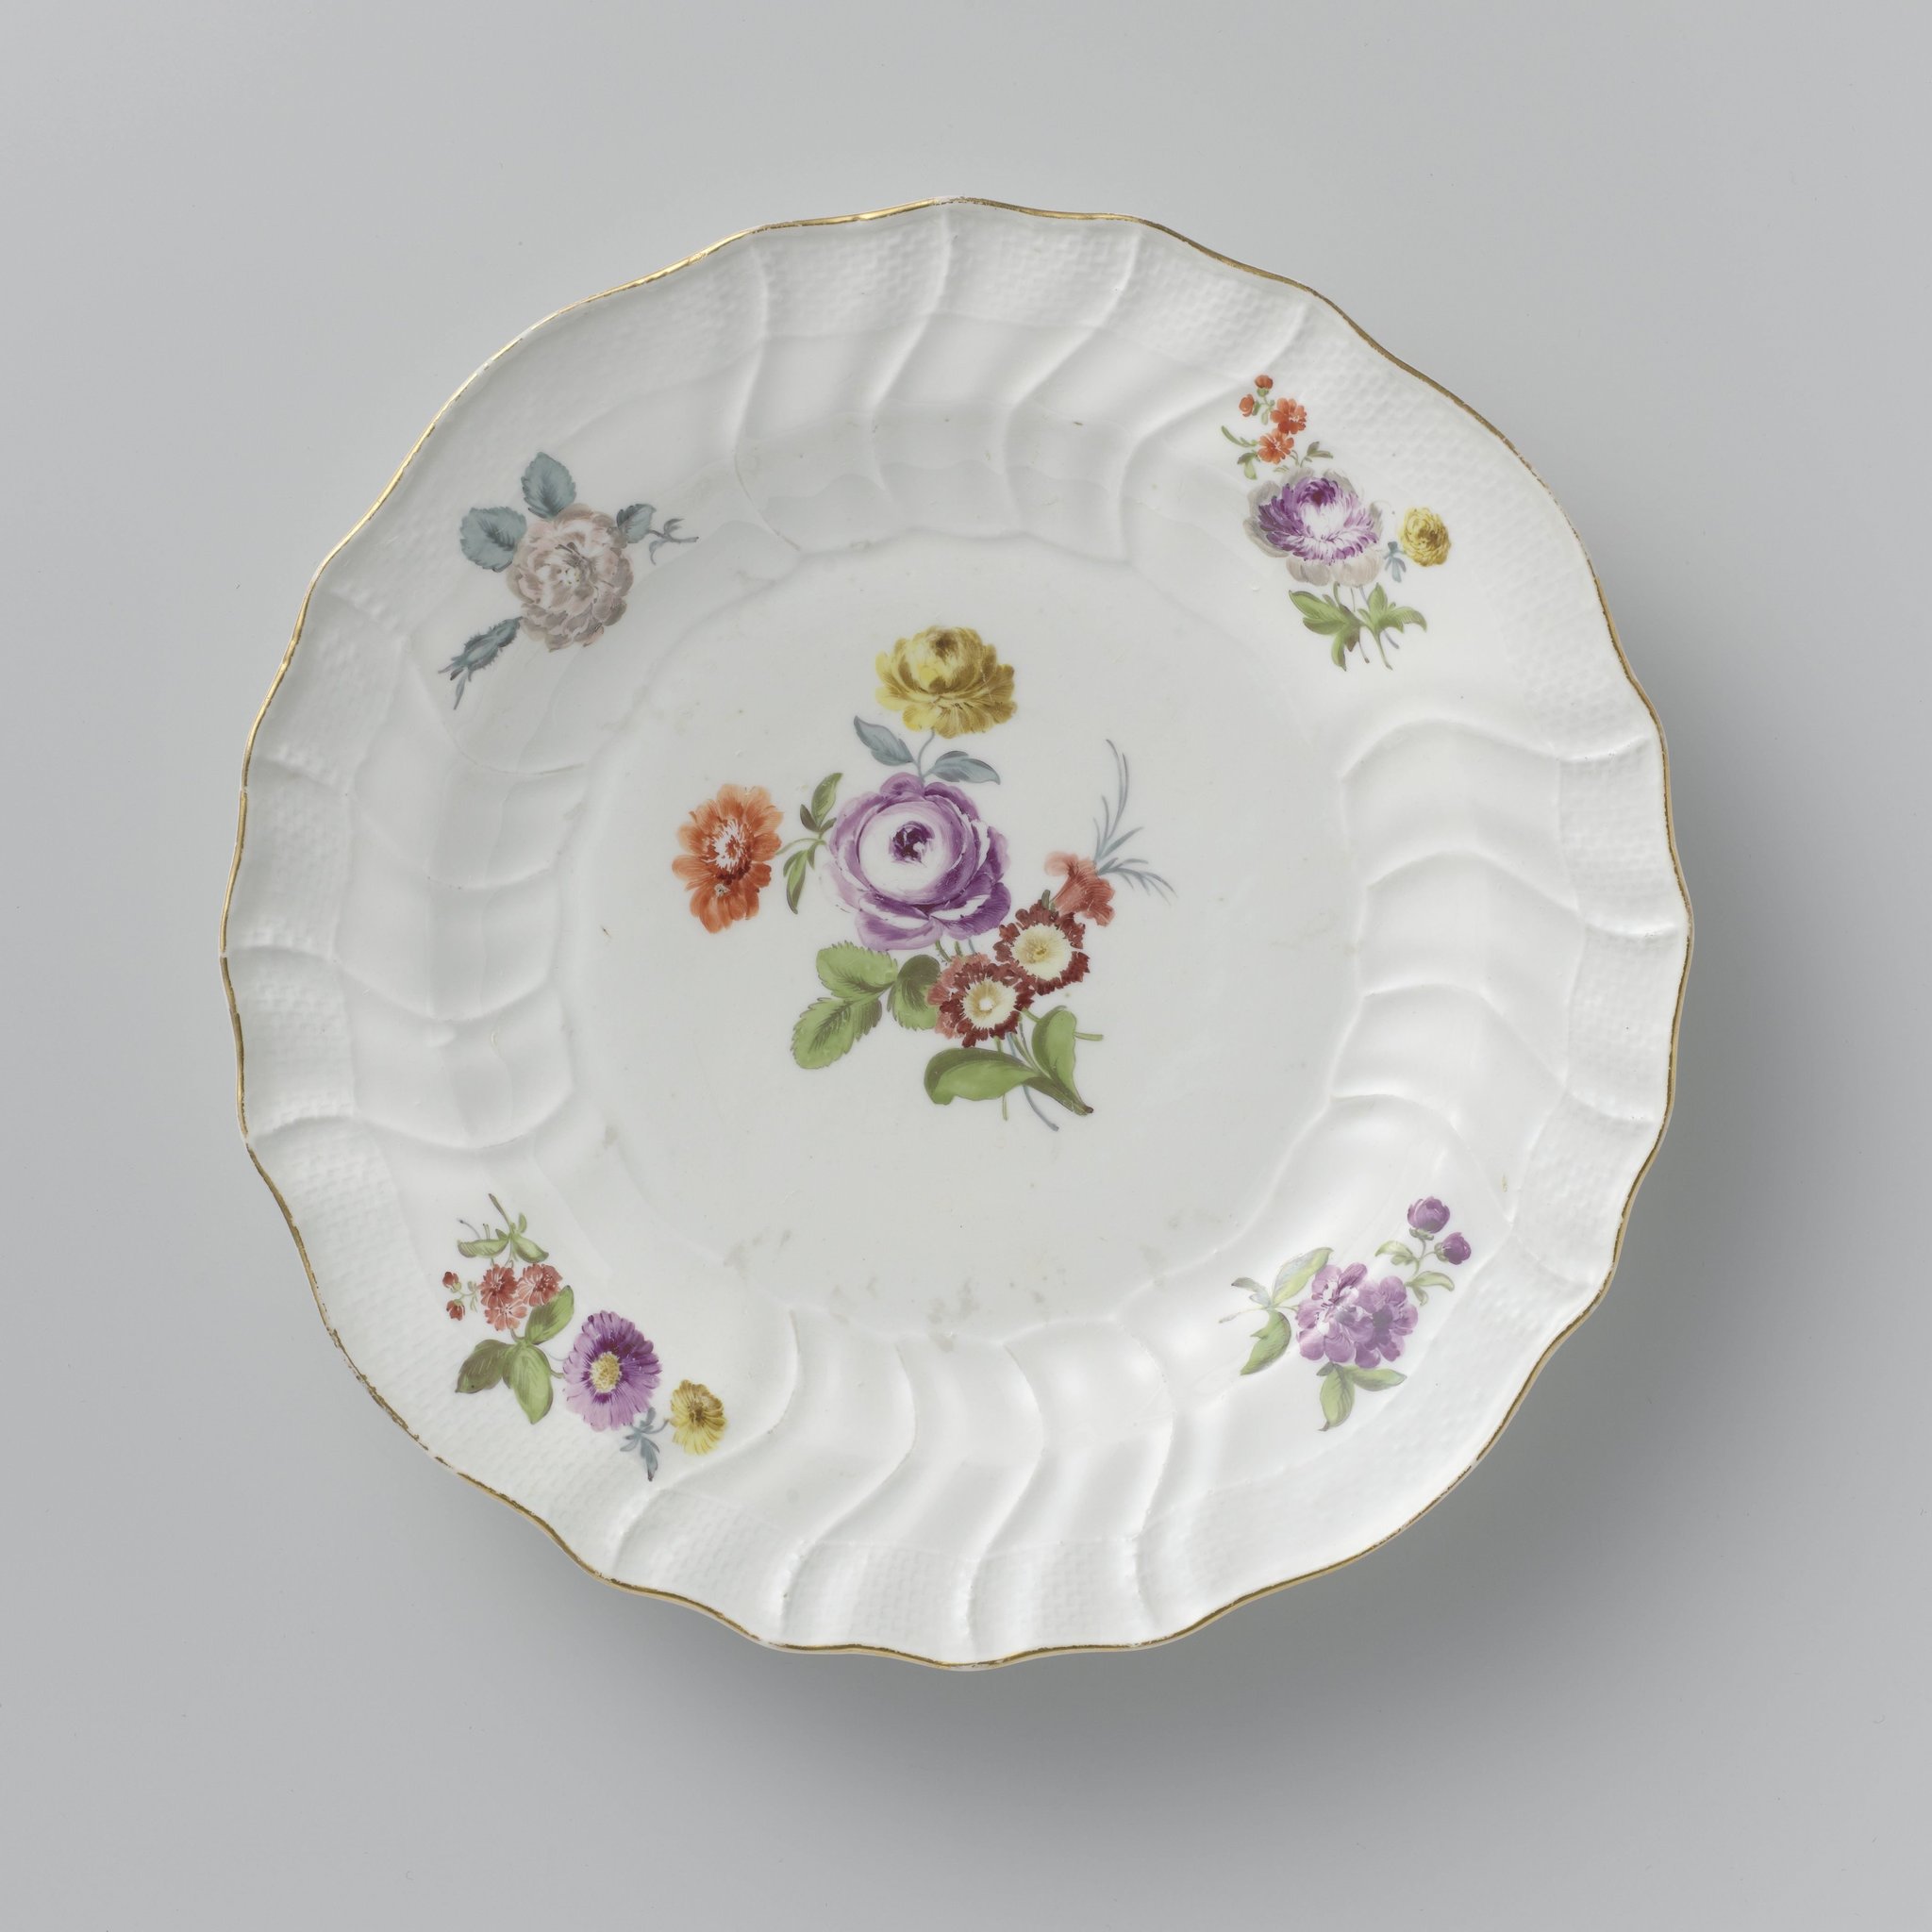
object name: eating drinking utensil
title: Bord, veelkleurig beschilderd met Deutsche Blumen, insekten en vruchten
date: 1750-1760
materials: porcelain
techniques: painted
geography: meissen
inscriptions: factory mark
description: Rond bord van beschilderd porselein. Het bord is beschilderd met Deutsche Blumen, insekten en vruchten. De rand is in reliëf versierd met het Neuozier-patroon. Het bord is gemerkt en hoort bij een servies (BK-17474-1 t/m BK-17474-253).